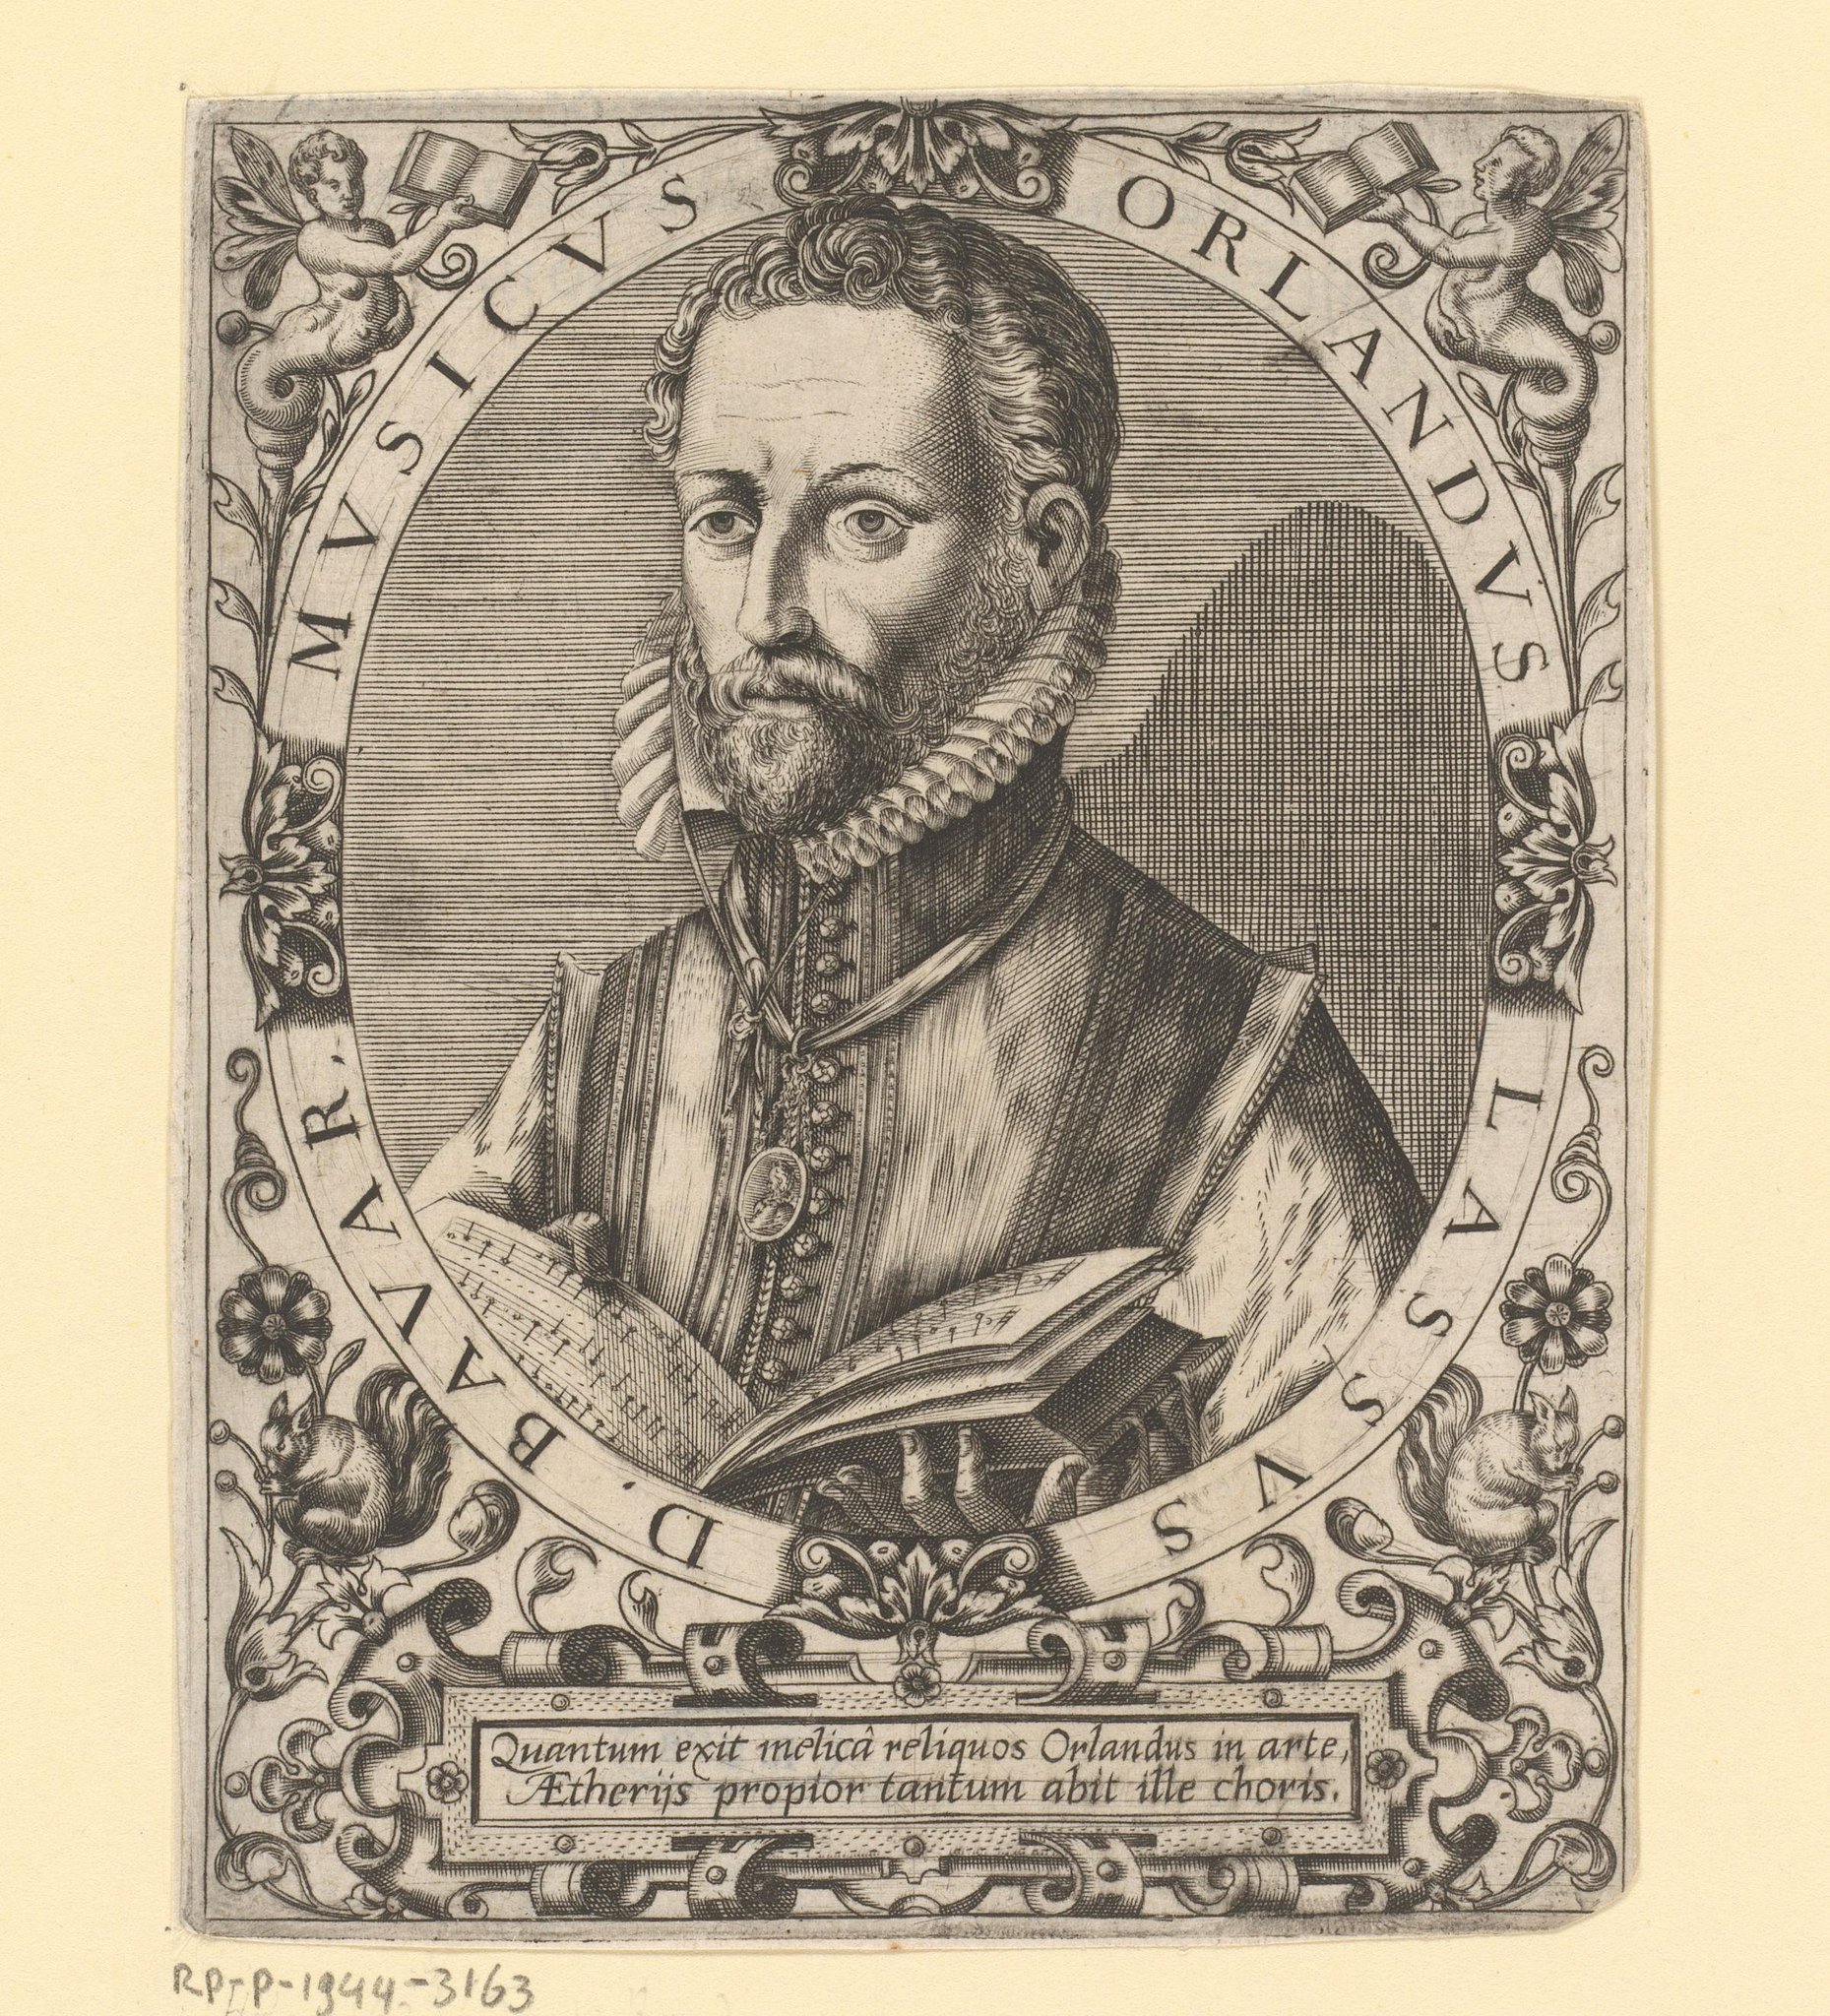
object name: print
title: Orlandus Lassus D. Bavar. musicus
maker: jean jacques boissard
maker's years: 1528-1598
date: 1598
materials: paper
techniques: engraving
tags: orlando di lasso, historical persons, portrait of composer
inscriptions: collector's mark: Lugt 2228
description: Prent uit: Boissard, Jean Jacques. Icones quinquaginta virorum illustrium doctrina & eruditione praestantium ad vivum effictae. 4 dln. Frankfurt am Main: s.n., 1597-1599, dl. 2, p. 286. Mogelijk ook gebruikt in latere edities. Latere staat van prent verschenen in: Boissard, Jean Jacques. Bibliotheca chalcographica. 8 dln. Frankfurt am Main: Johannes Ammon, 1650-1652. Ook gebruikt in latere edities.